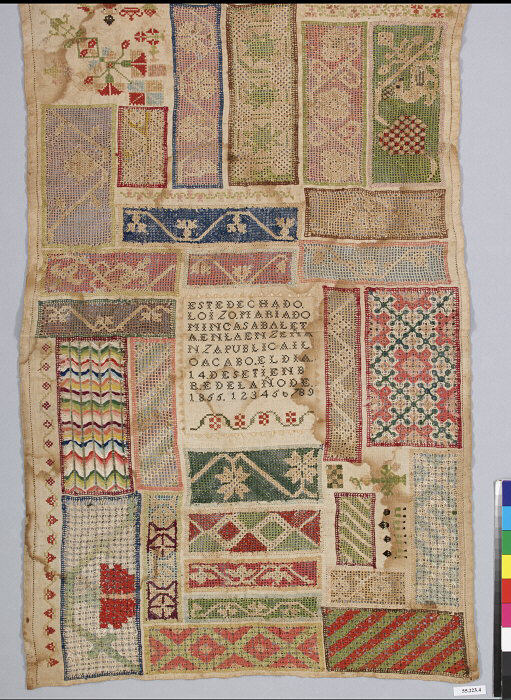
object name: sampler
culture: mexican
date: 1855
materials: linen, metal thread, silk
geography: mexico